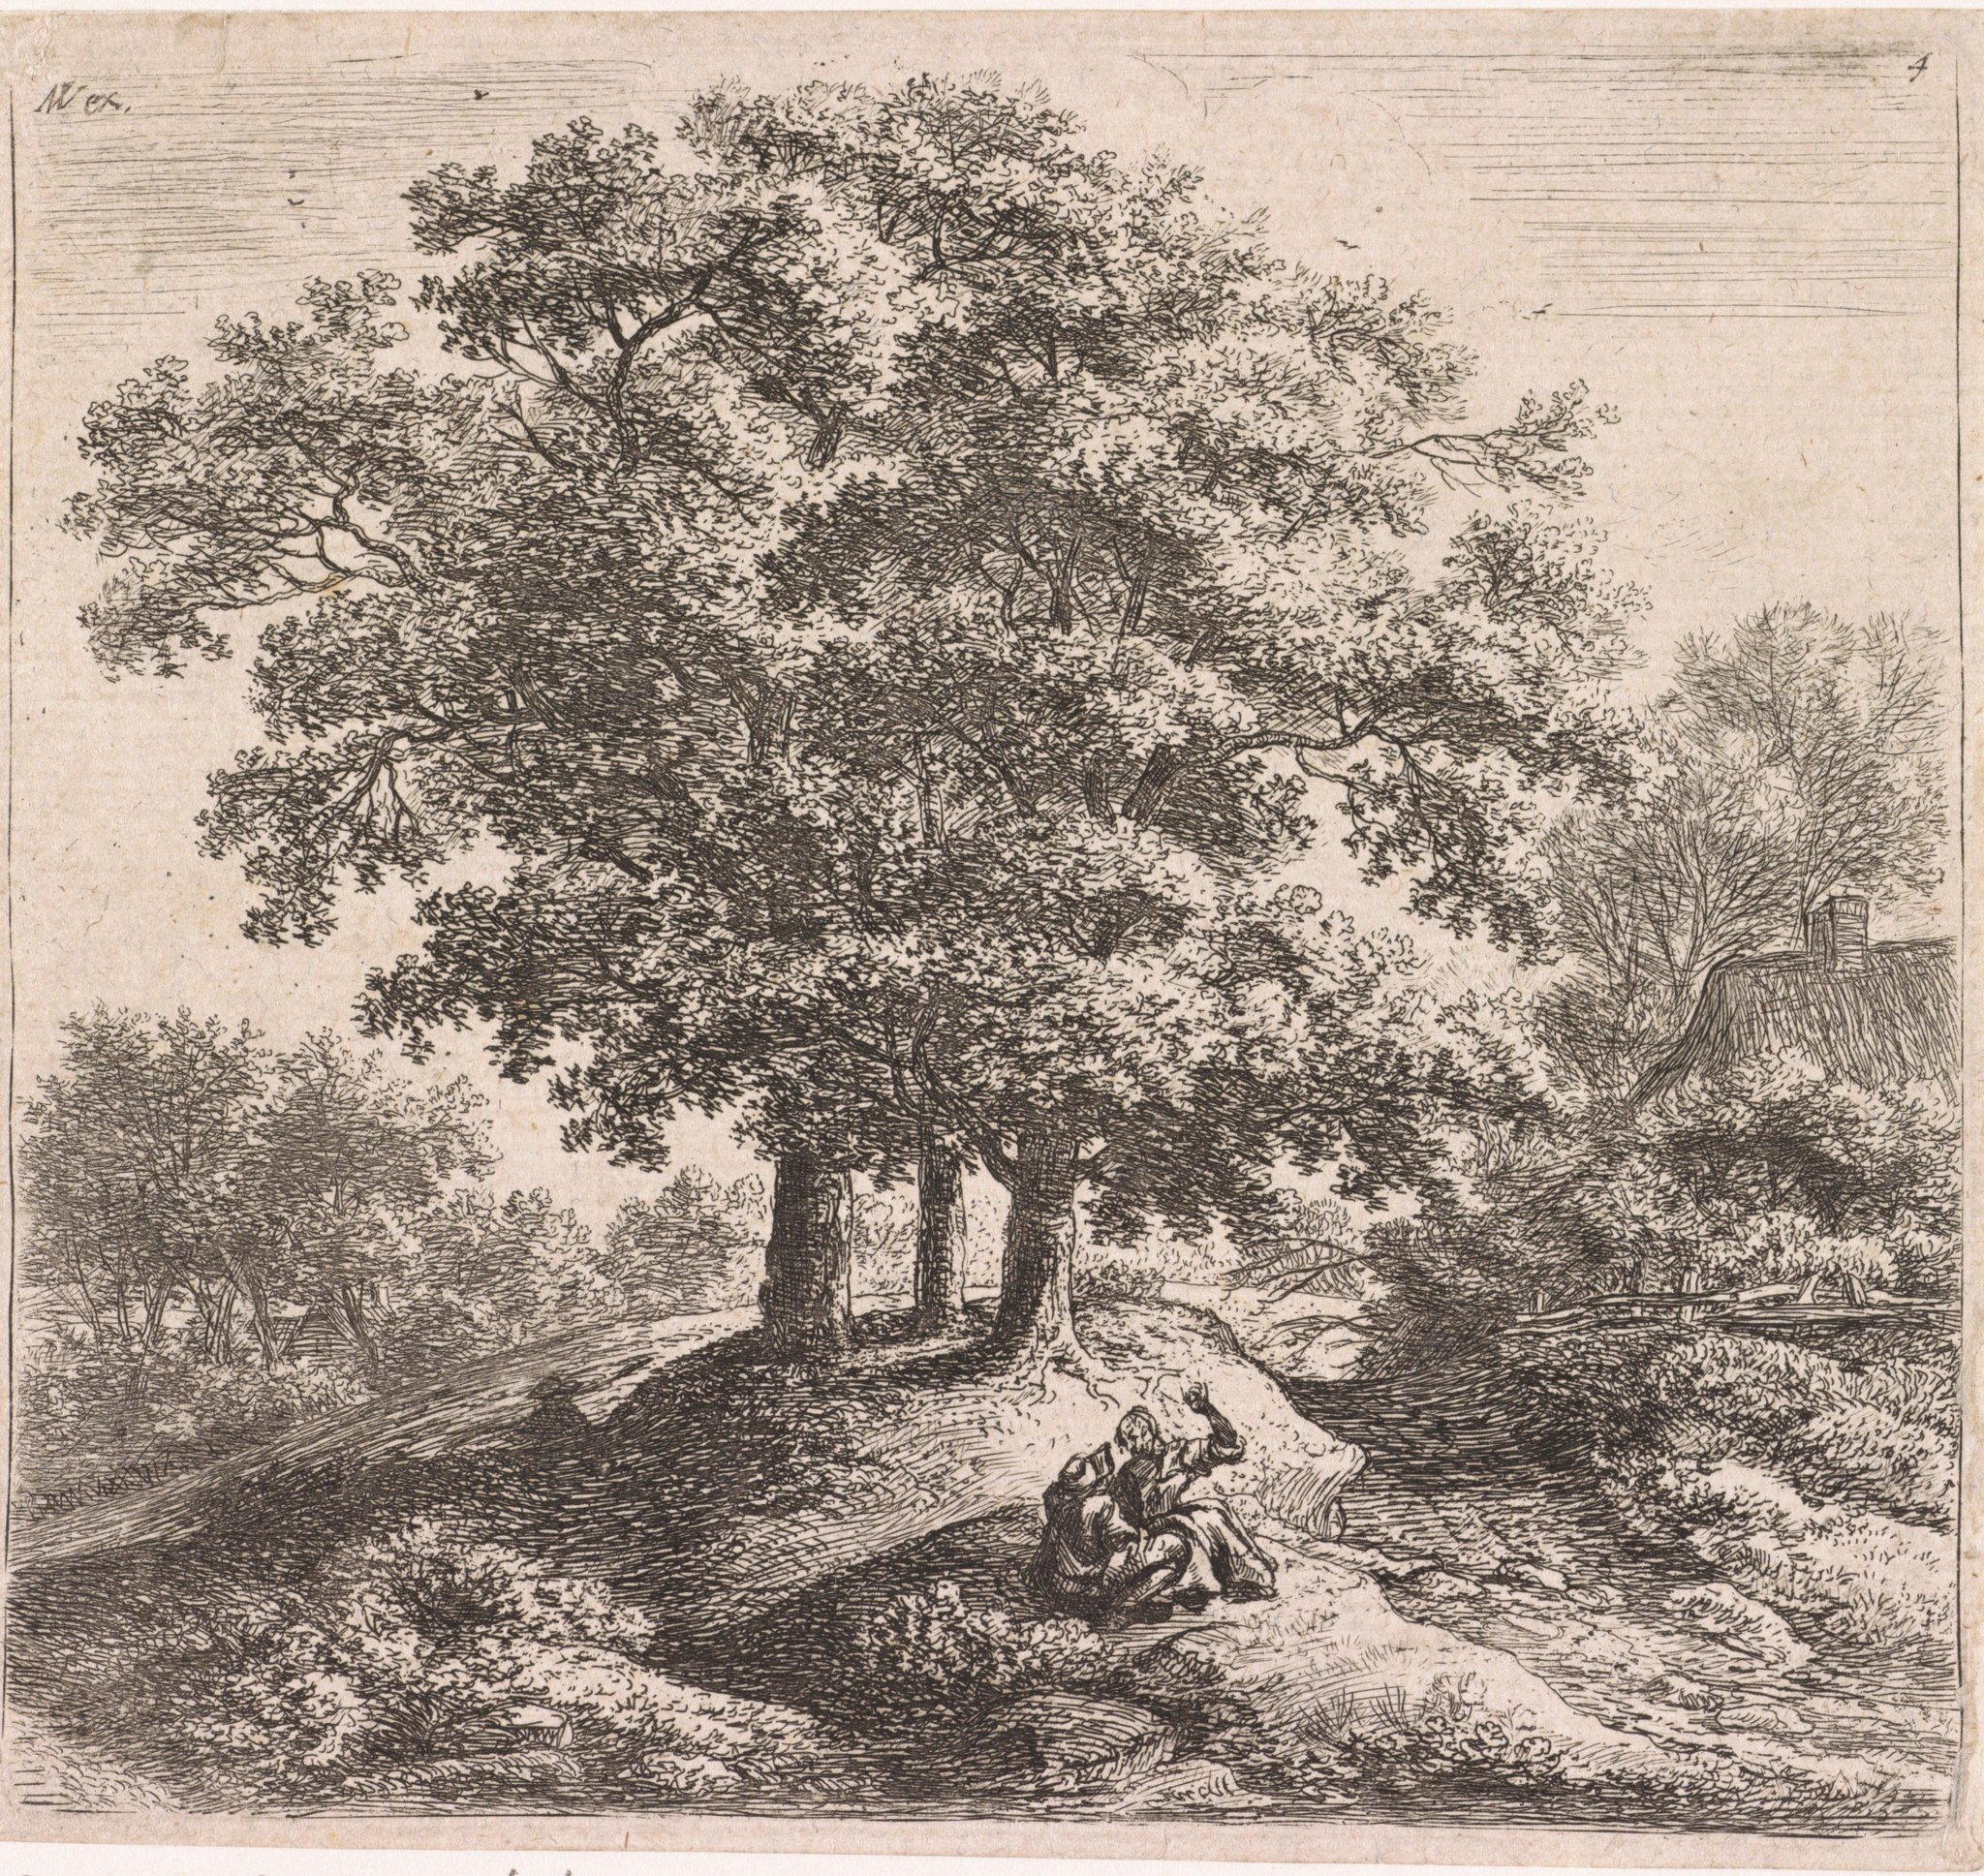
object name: print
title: Twee figuren op een heuvel bij een huis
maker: anthonie waterloo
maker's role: draughtsman, painter, print maker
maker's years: 1609-1690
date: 1630-1663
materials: paper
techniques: etching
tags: forest, wood, sitting on the ground, sitting on the ground - aa - female human figure, landscapes (+ landscape with figures, staffage), farm or solitary house in landscape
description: Een man en een vrouw zitten op een kleine heuvel voor een groep bomen. Links is het silhouet van een derde figuur op een pad te zien. Rechts staat een huis.